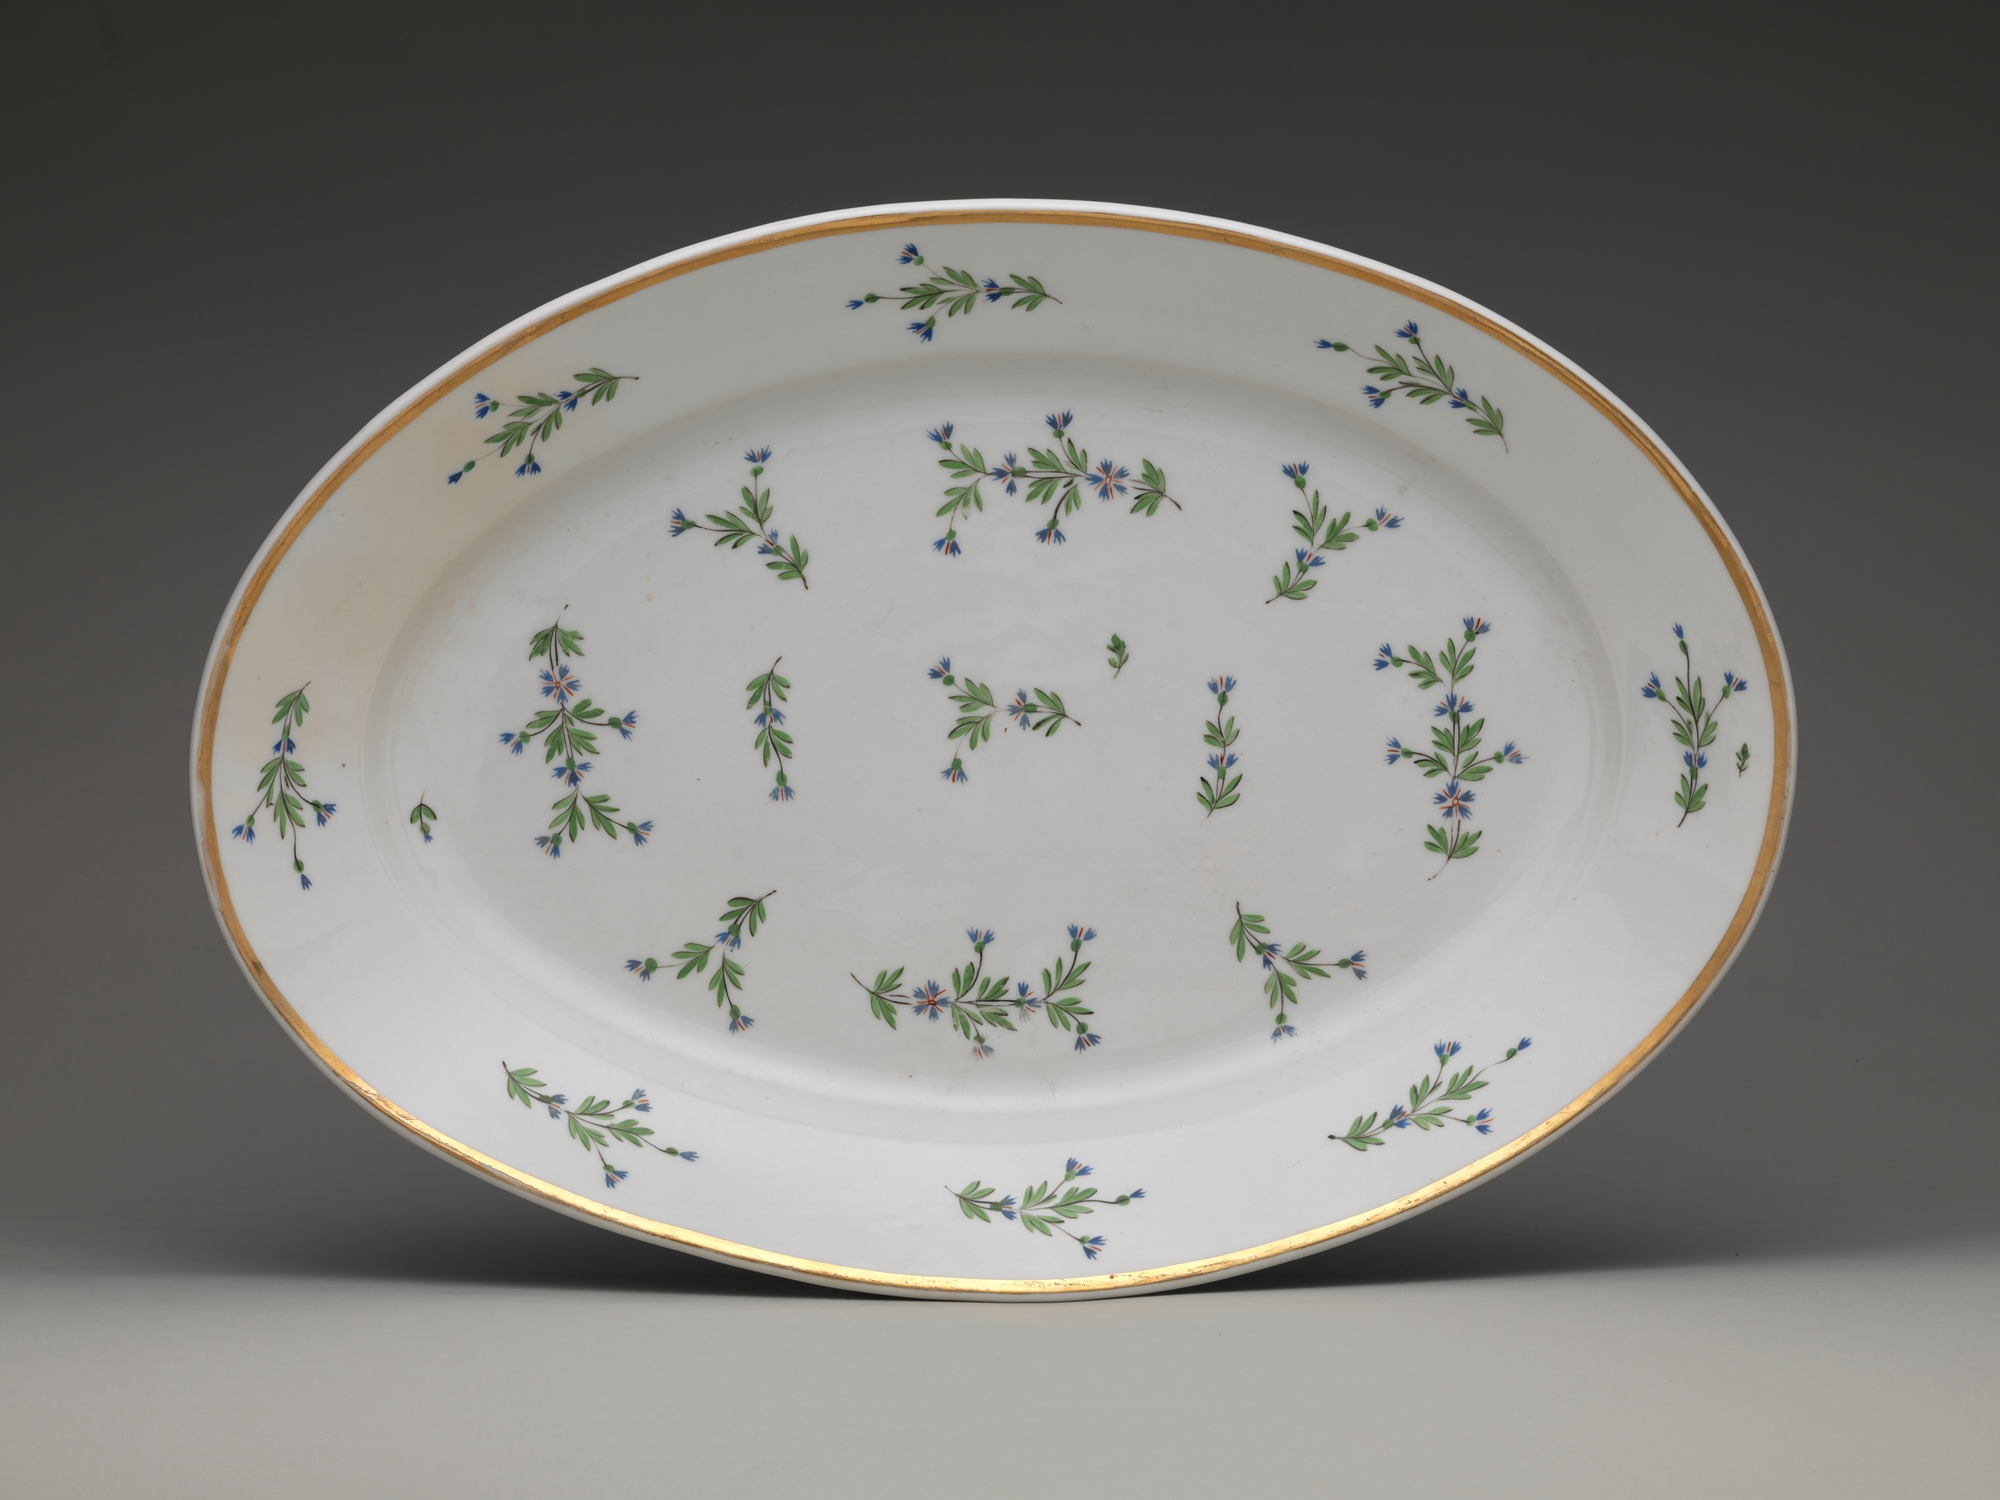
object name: platter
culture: french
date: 1815-1830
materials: porcelain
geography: france